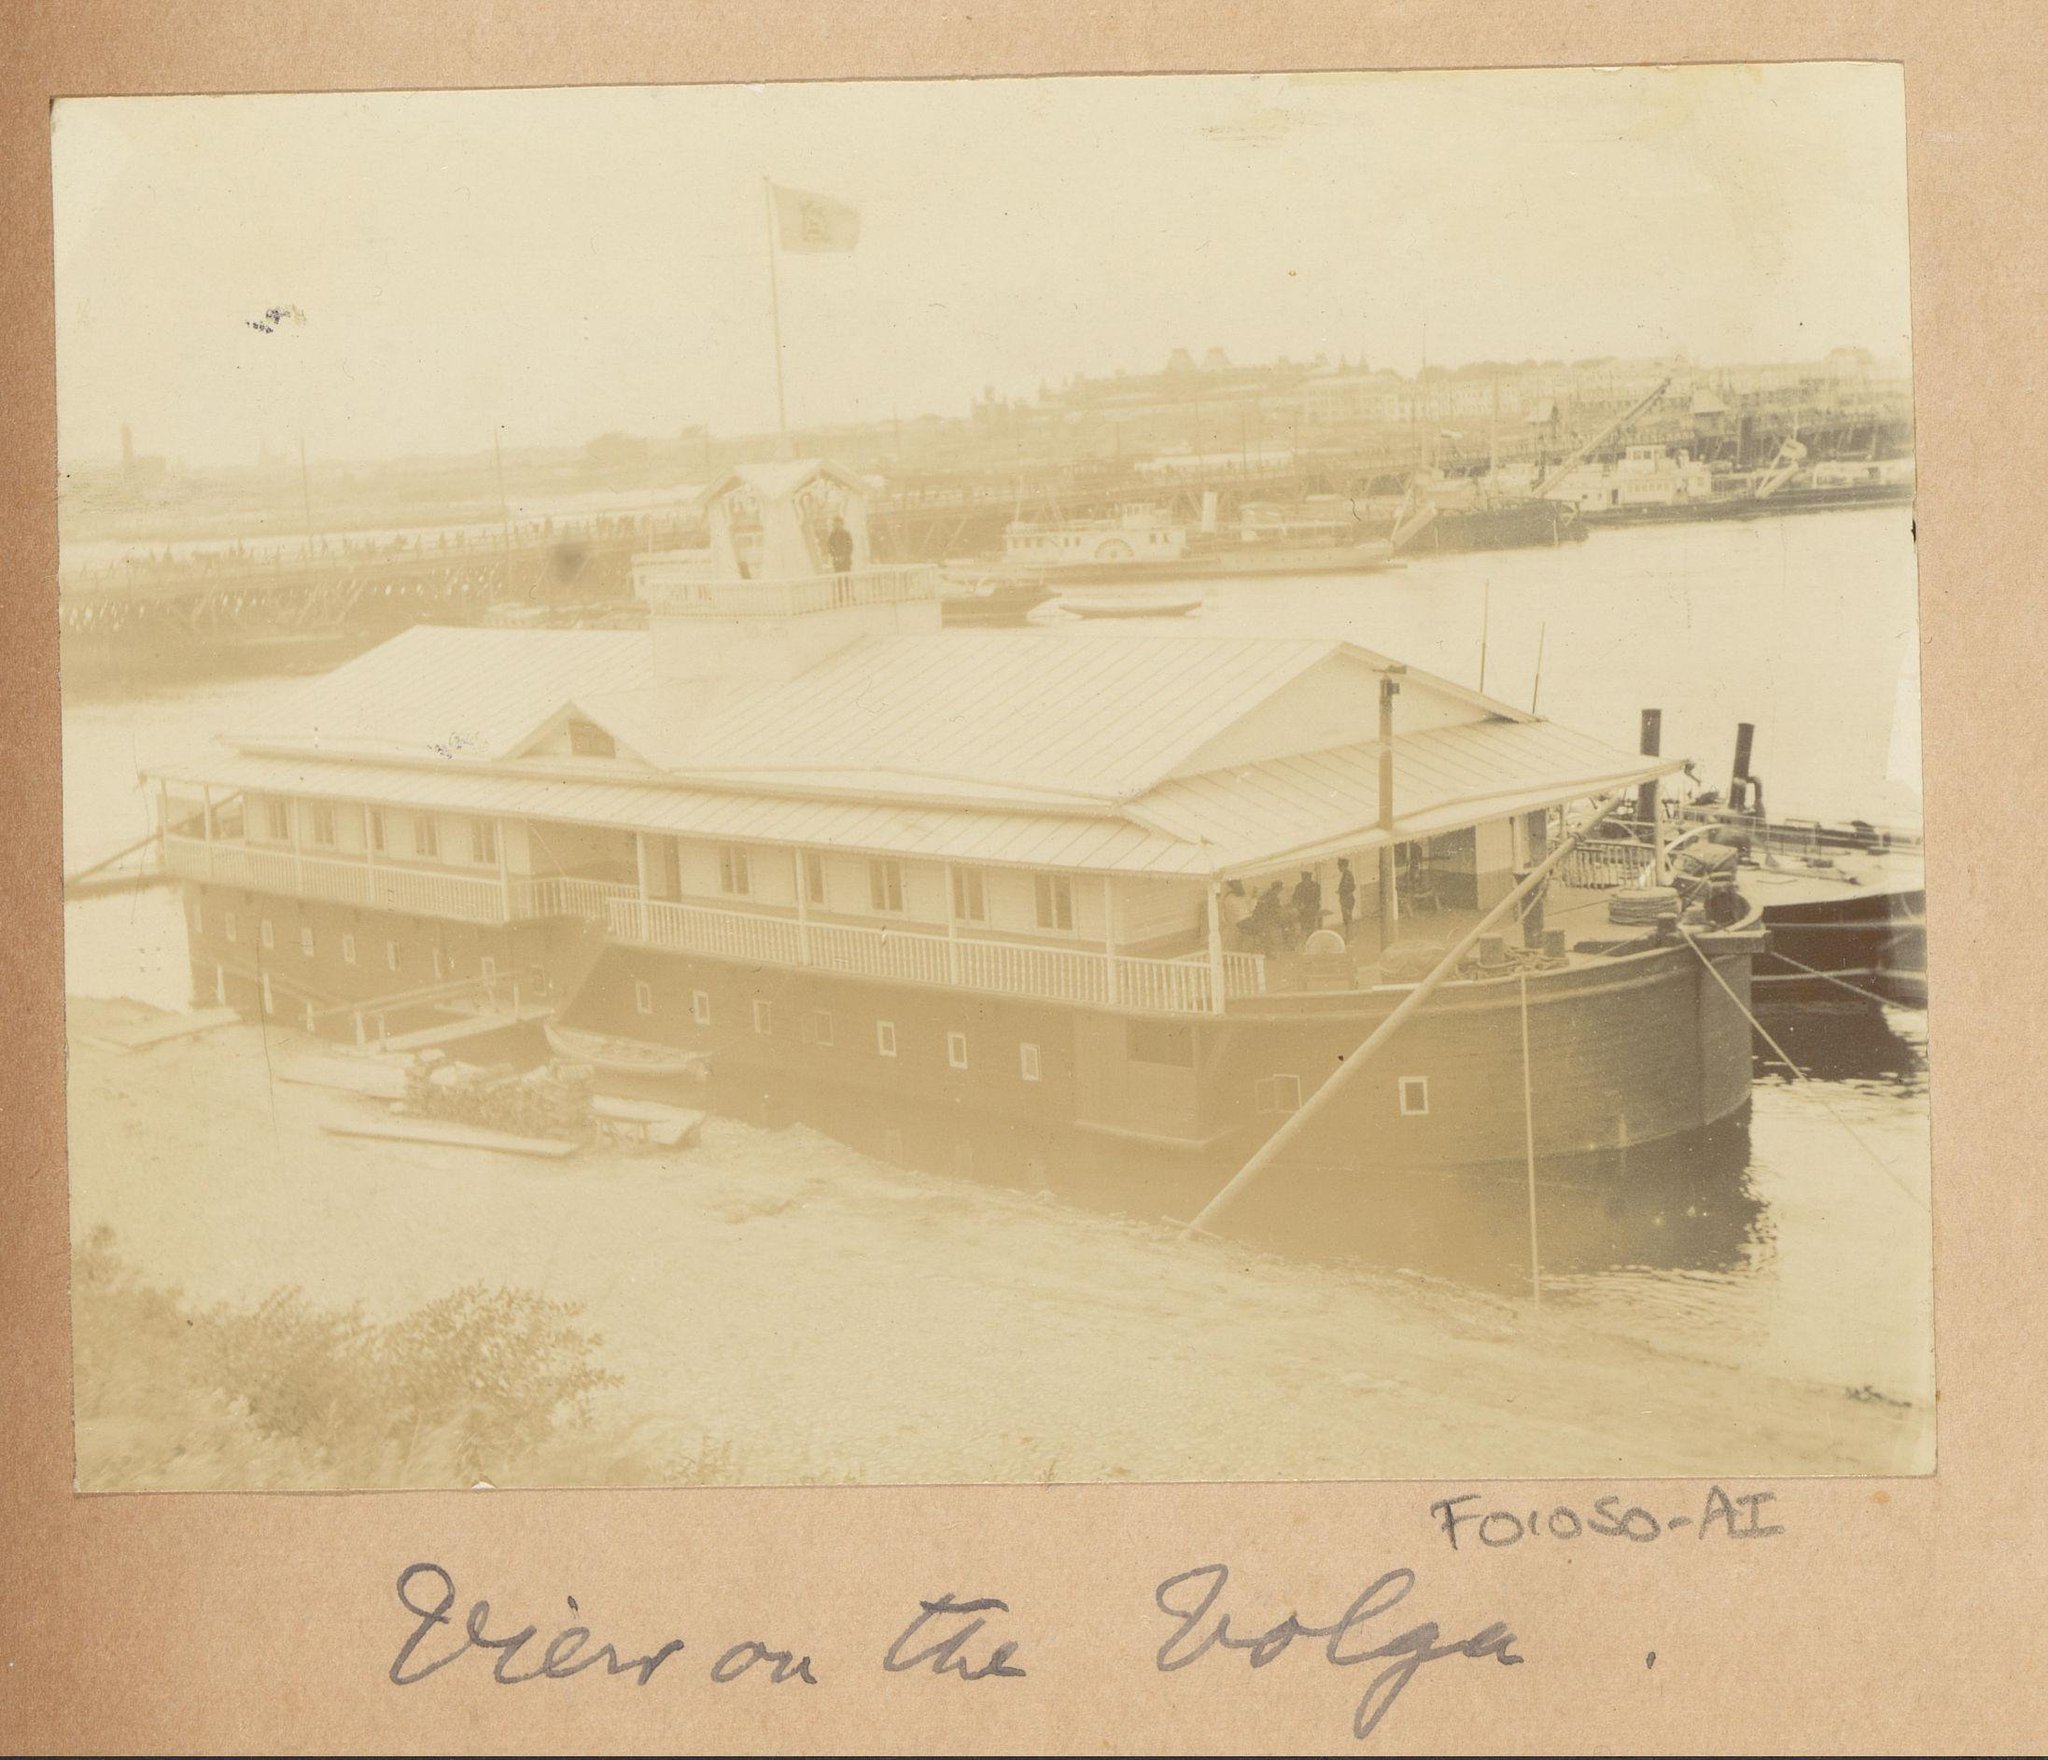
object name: photograph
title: Ark aan de kade op de Wolga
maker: joseph cheetham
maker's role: engineer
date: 1903-1904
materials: photographic support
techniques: gelatin silver print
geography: russia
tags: houseboat, pier, quay, wharf, russia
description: Onderdeel van Fotoalbum van de Engelse familie Cheetham met opnames van hun verblijf in Rusland.